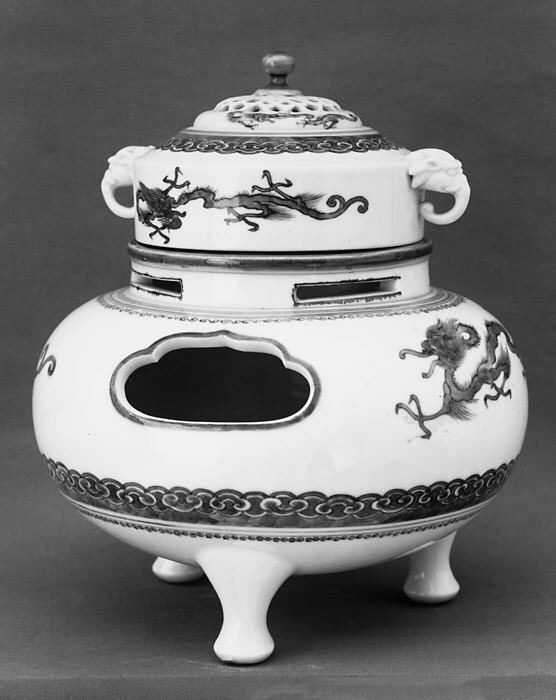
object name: clove boiler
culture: japanese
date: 1760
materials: glaze, porcelain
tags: dragons